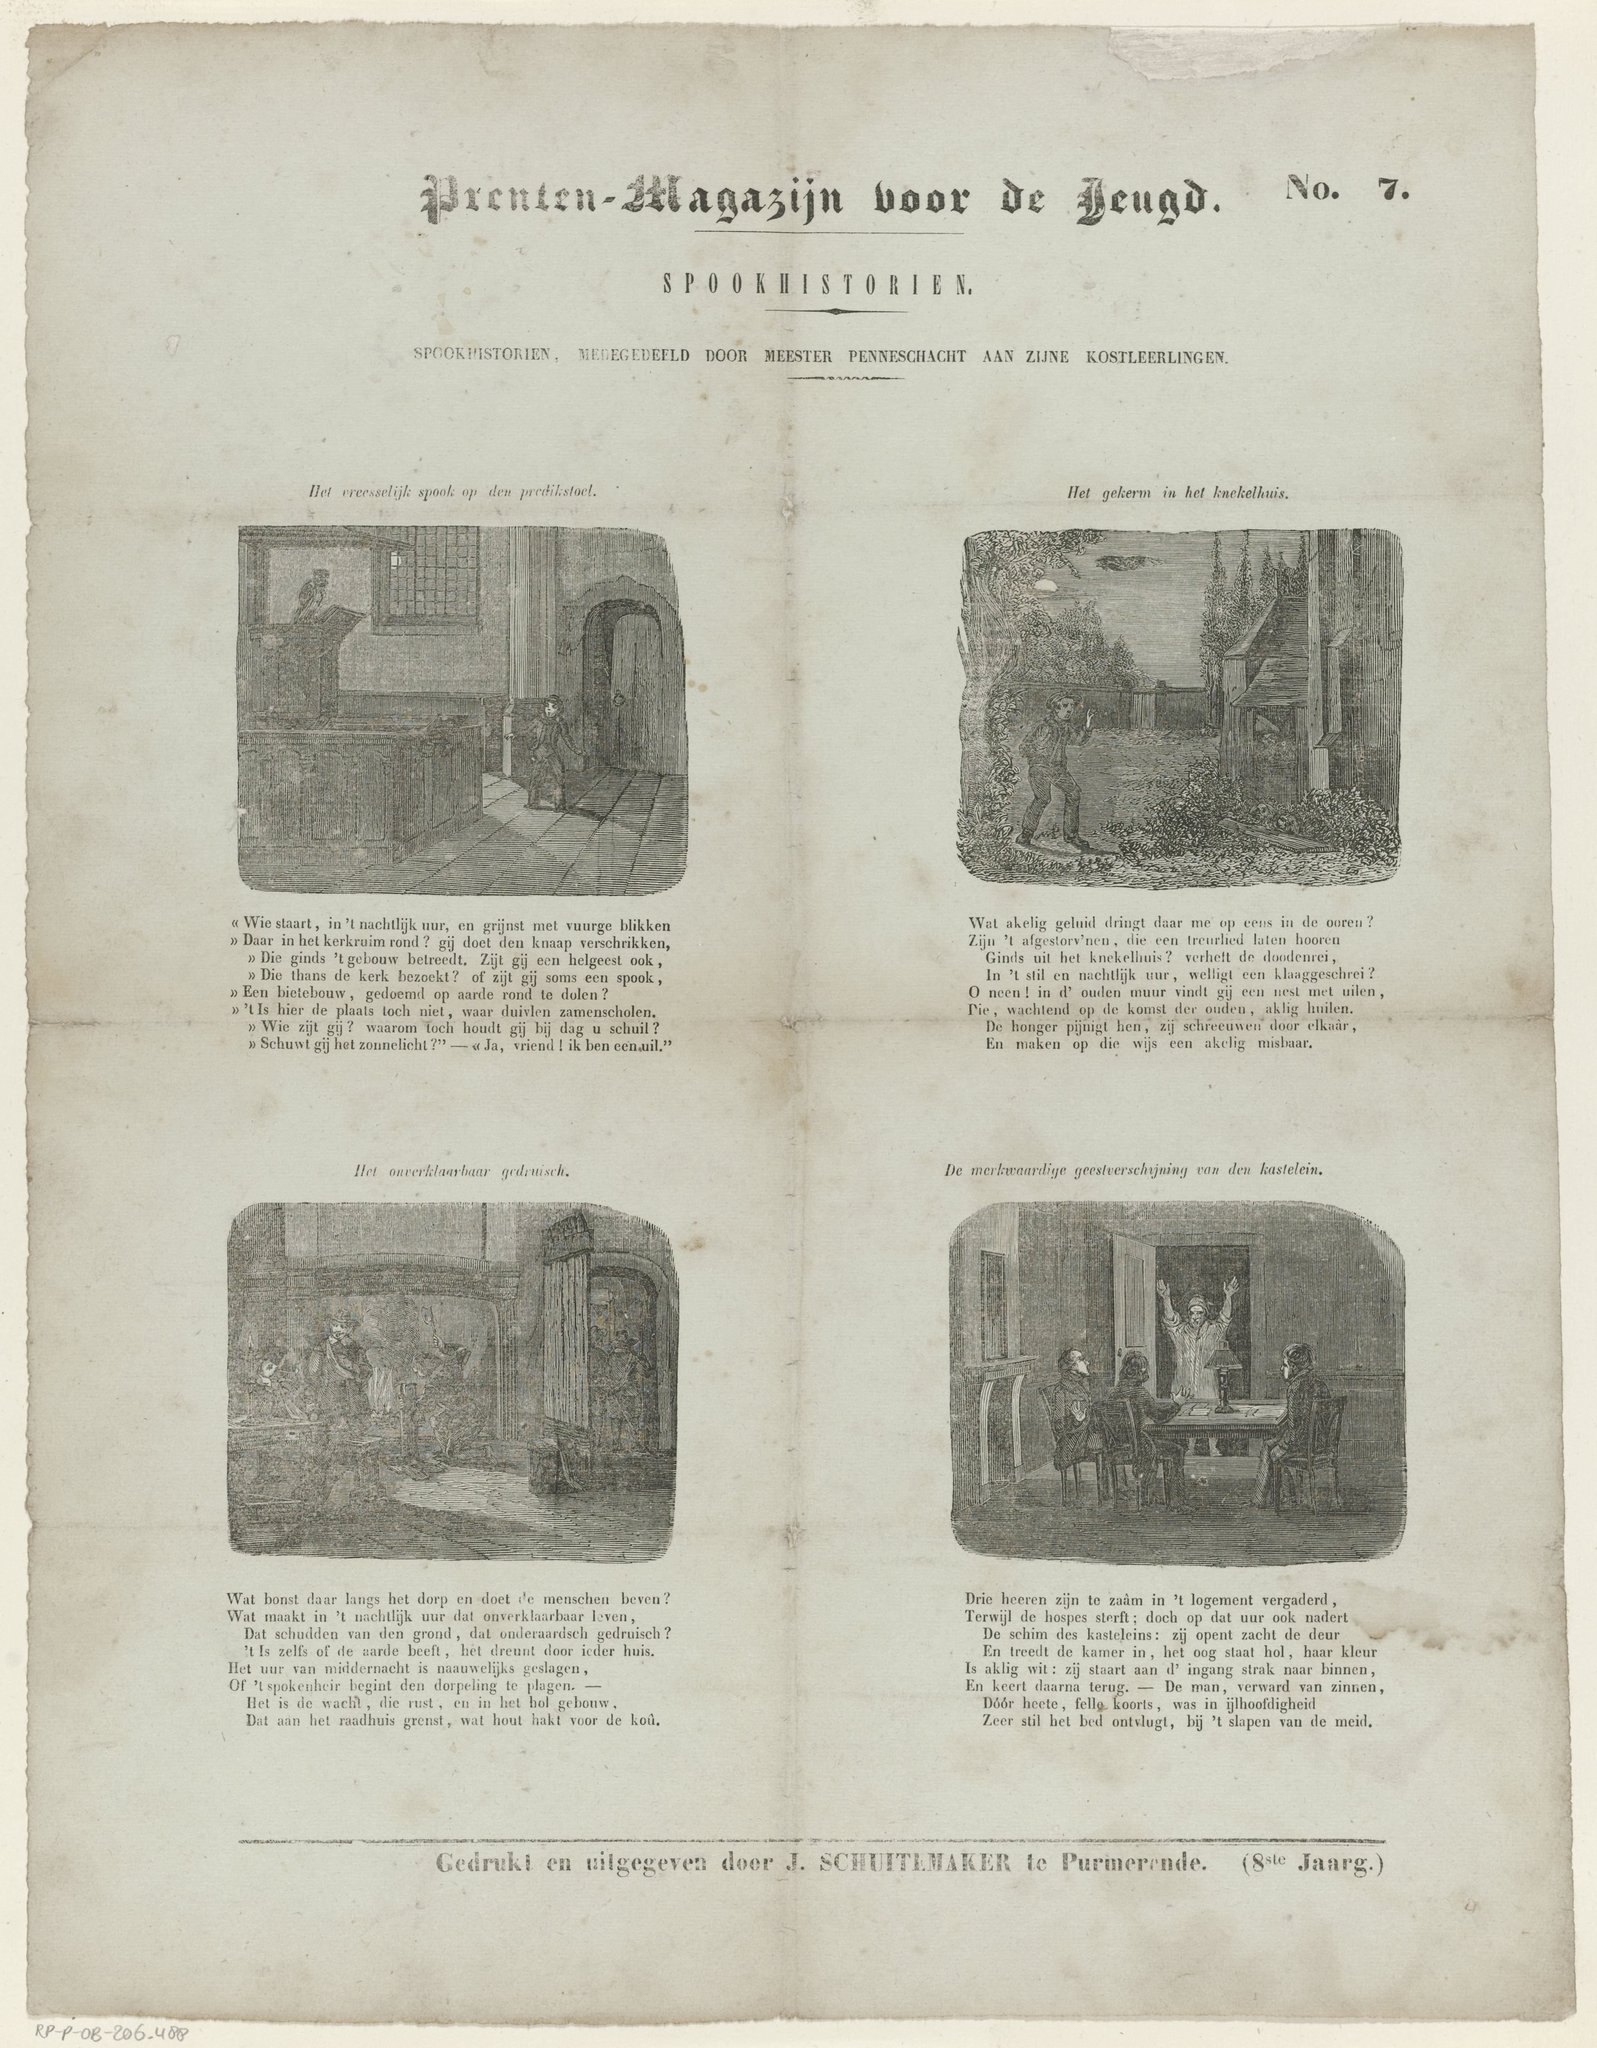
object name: popular print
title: Spookhistoriën, medegedeeld door Meester Penneschacht aan zijne kostleerlingen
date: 1849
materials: paper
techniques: letterpress printing, engraving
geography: netherlands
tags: tales and fairy tales, spirit, ghost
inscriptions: collector's mark: Lugt 2760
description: Blad met 4 scènes uit een spookverhaal. Boven elke voorstelling een titel en onder elke voorstelling een achtregelig vers. Genummerd rechtsboven: No. 7.